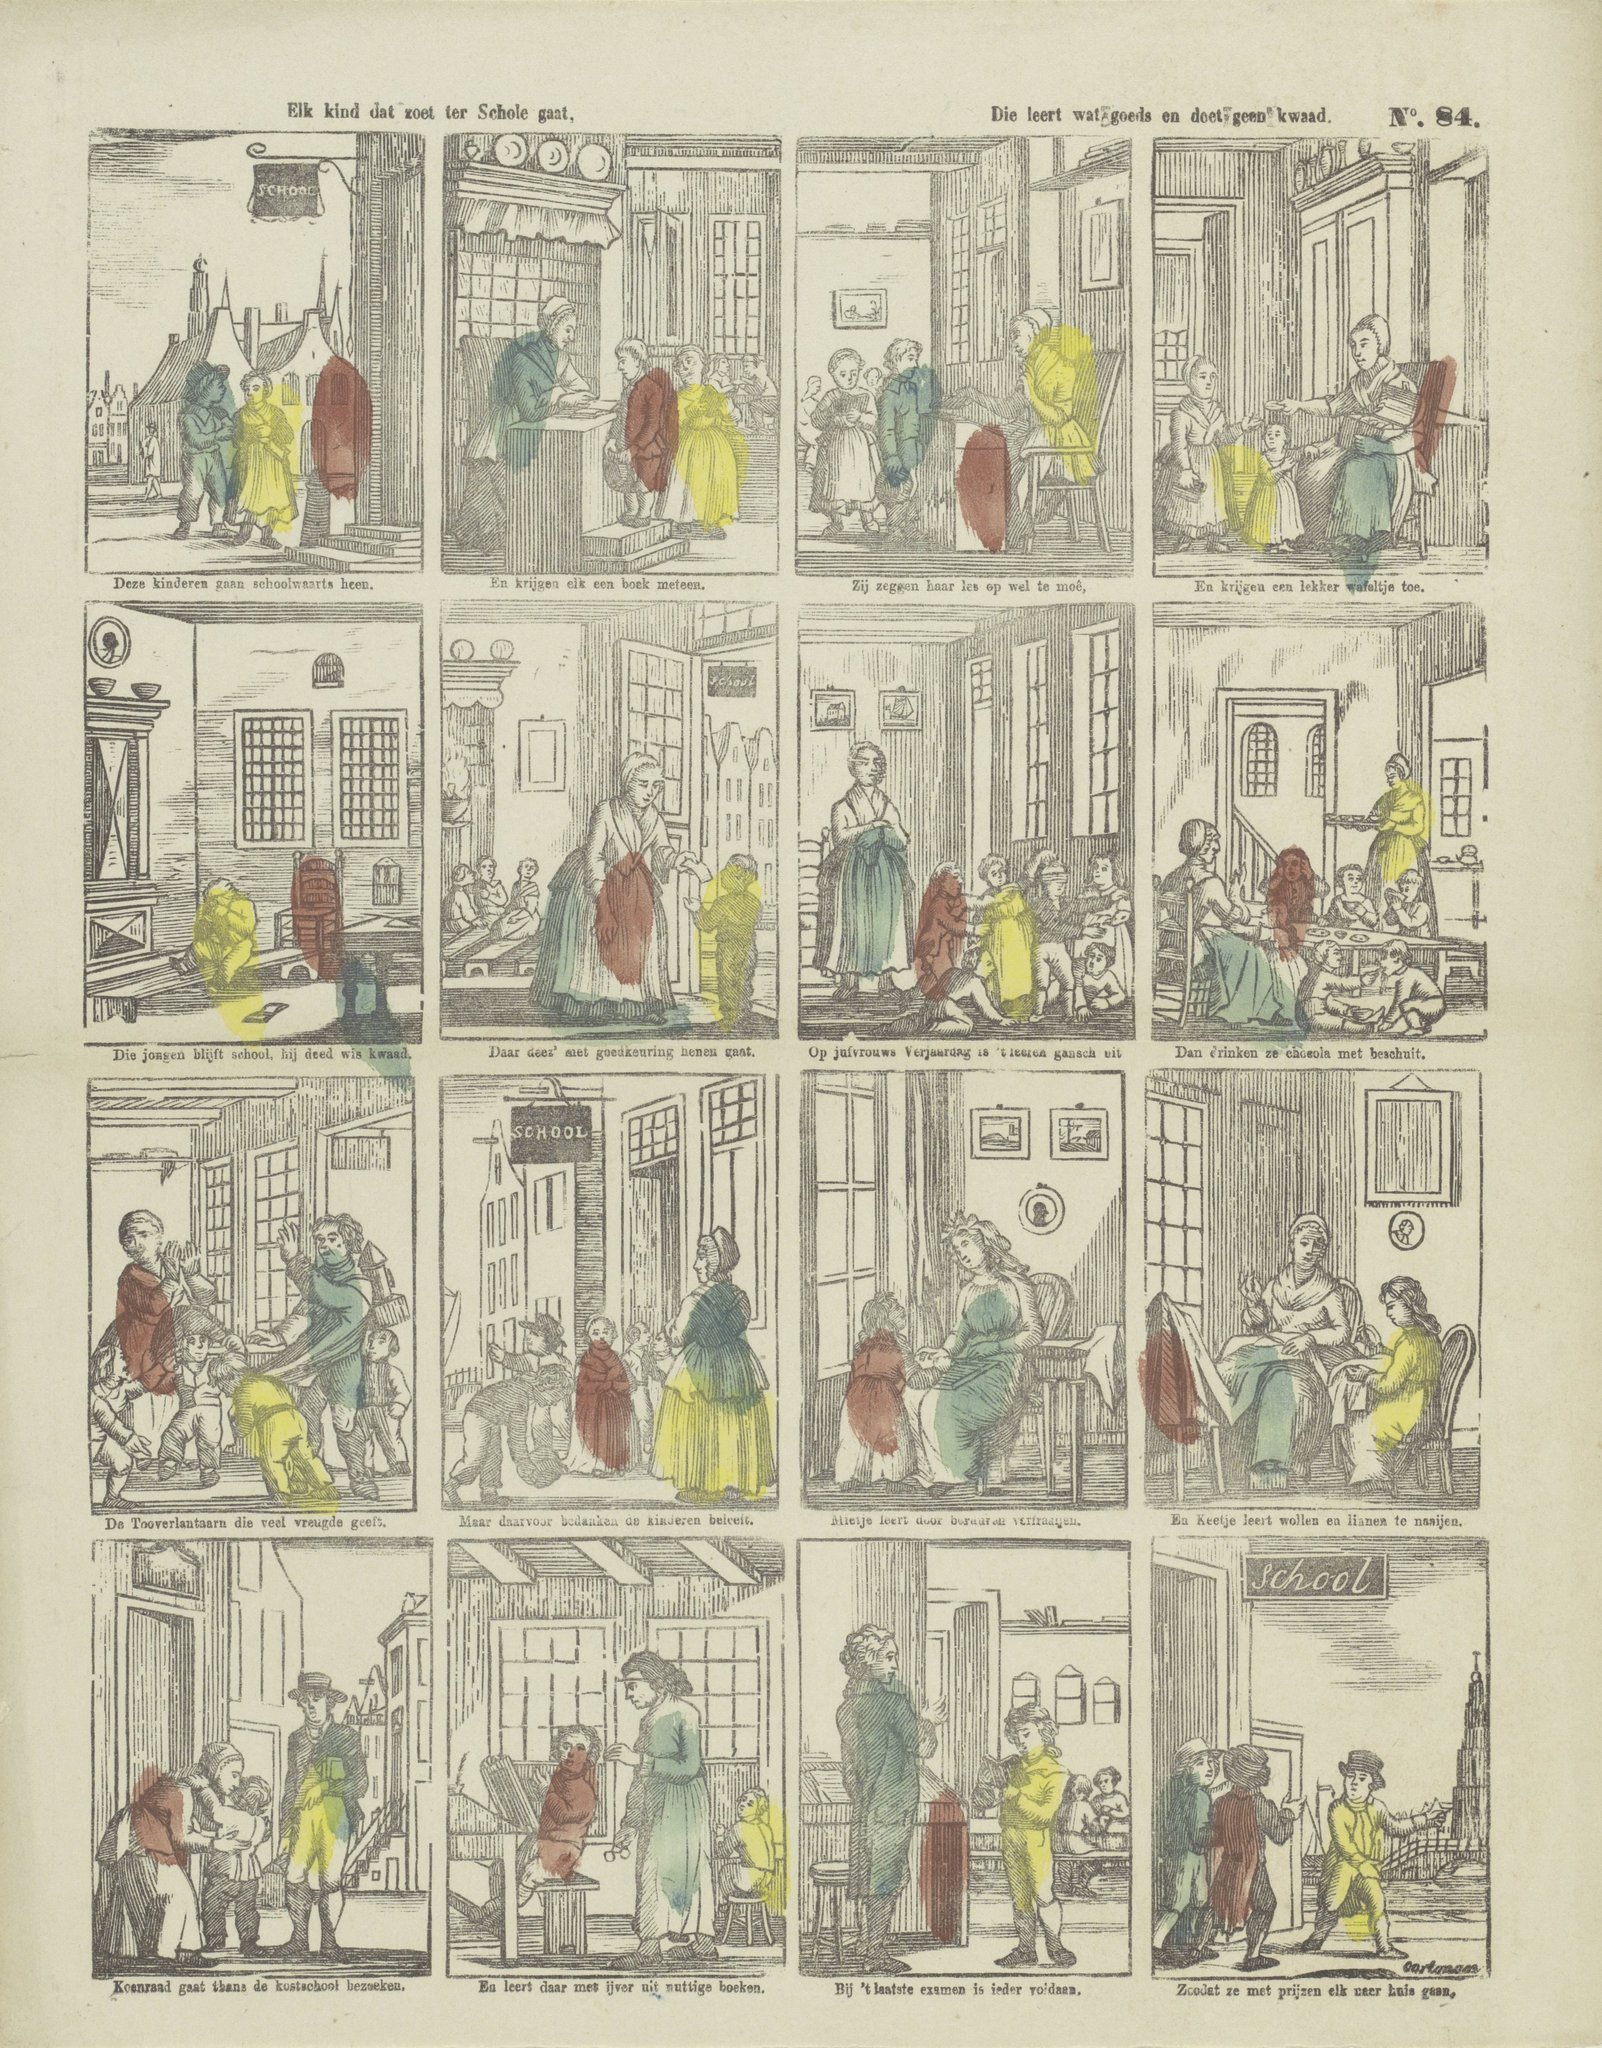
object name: print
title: Elk kind dat zoet ter schoole gaat. / Die leert wat goeds en doet geen kwaad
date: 1850-1870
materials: paper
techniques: colour, letterpress printing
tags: child and school (~ games and plays), going to school, games at school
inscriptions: collector's mark: Lugt 2760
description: Blad met 16 voorstellingen van schoolgaande kinderen. Onder elke voorstelling een onderschrift. Genummerd rechtsboven: No. 84.